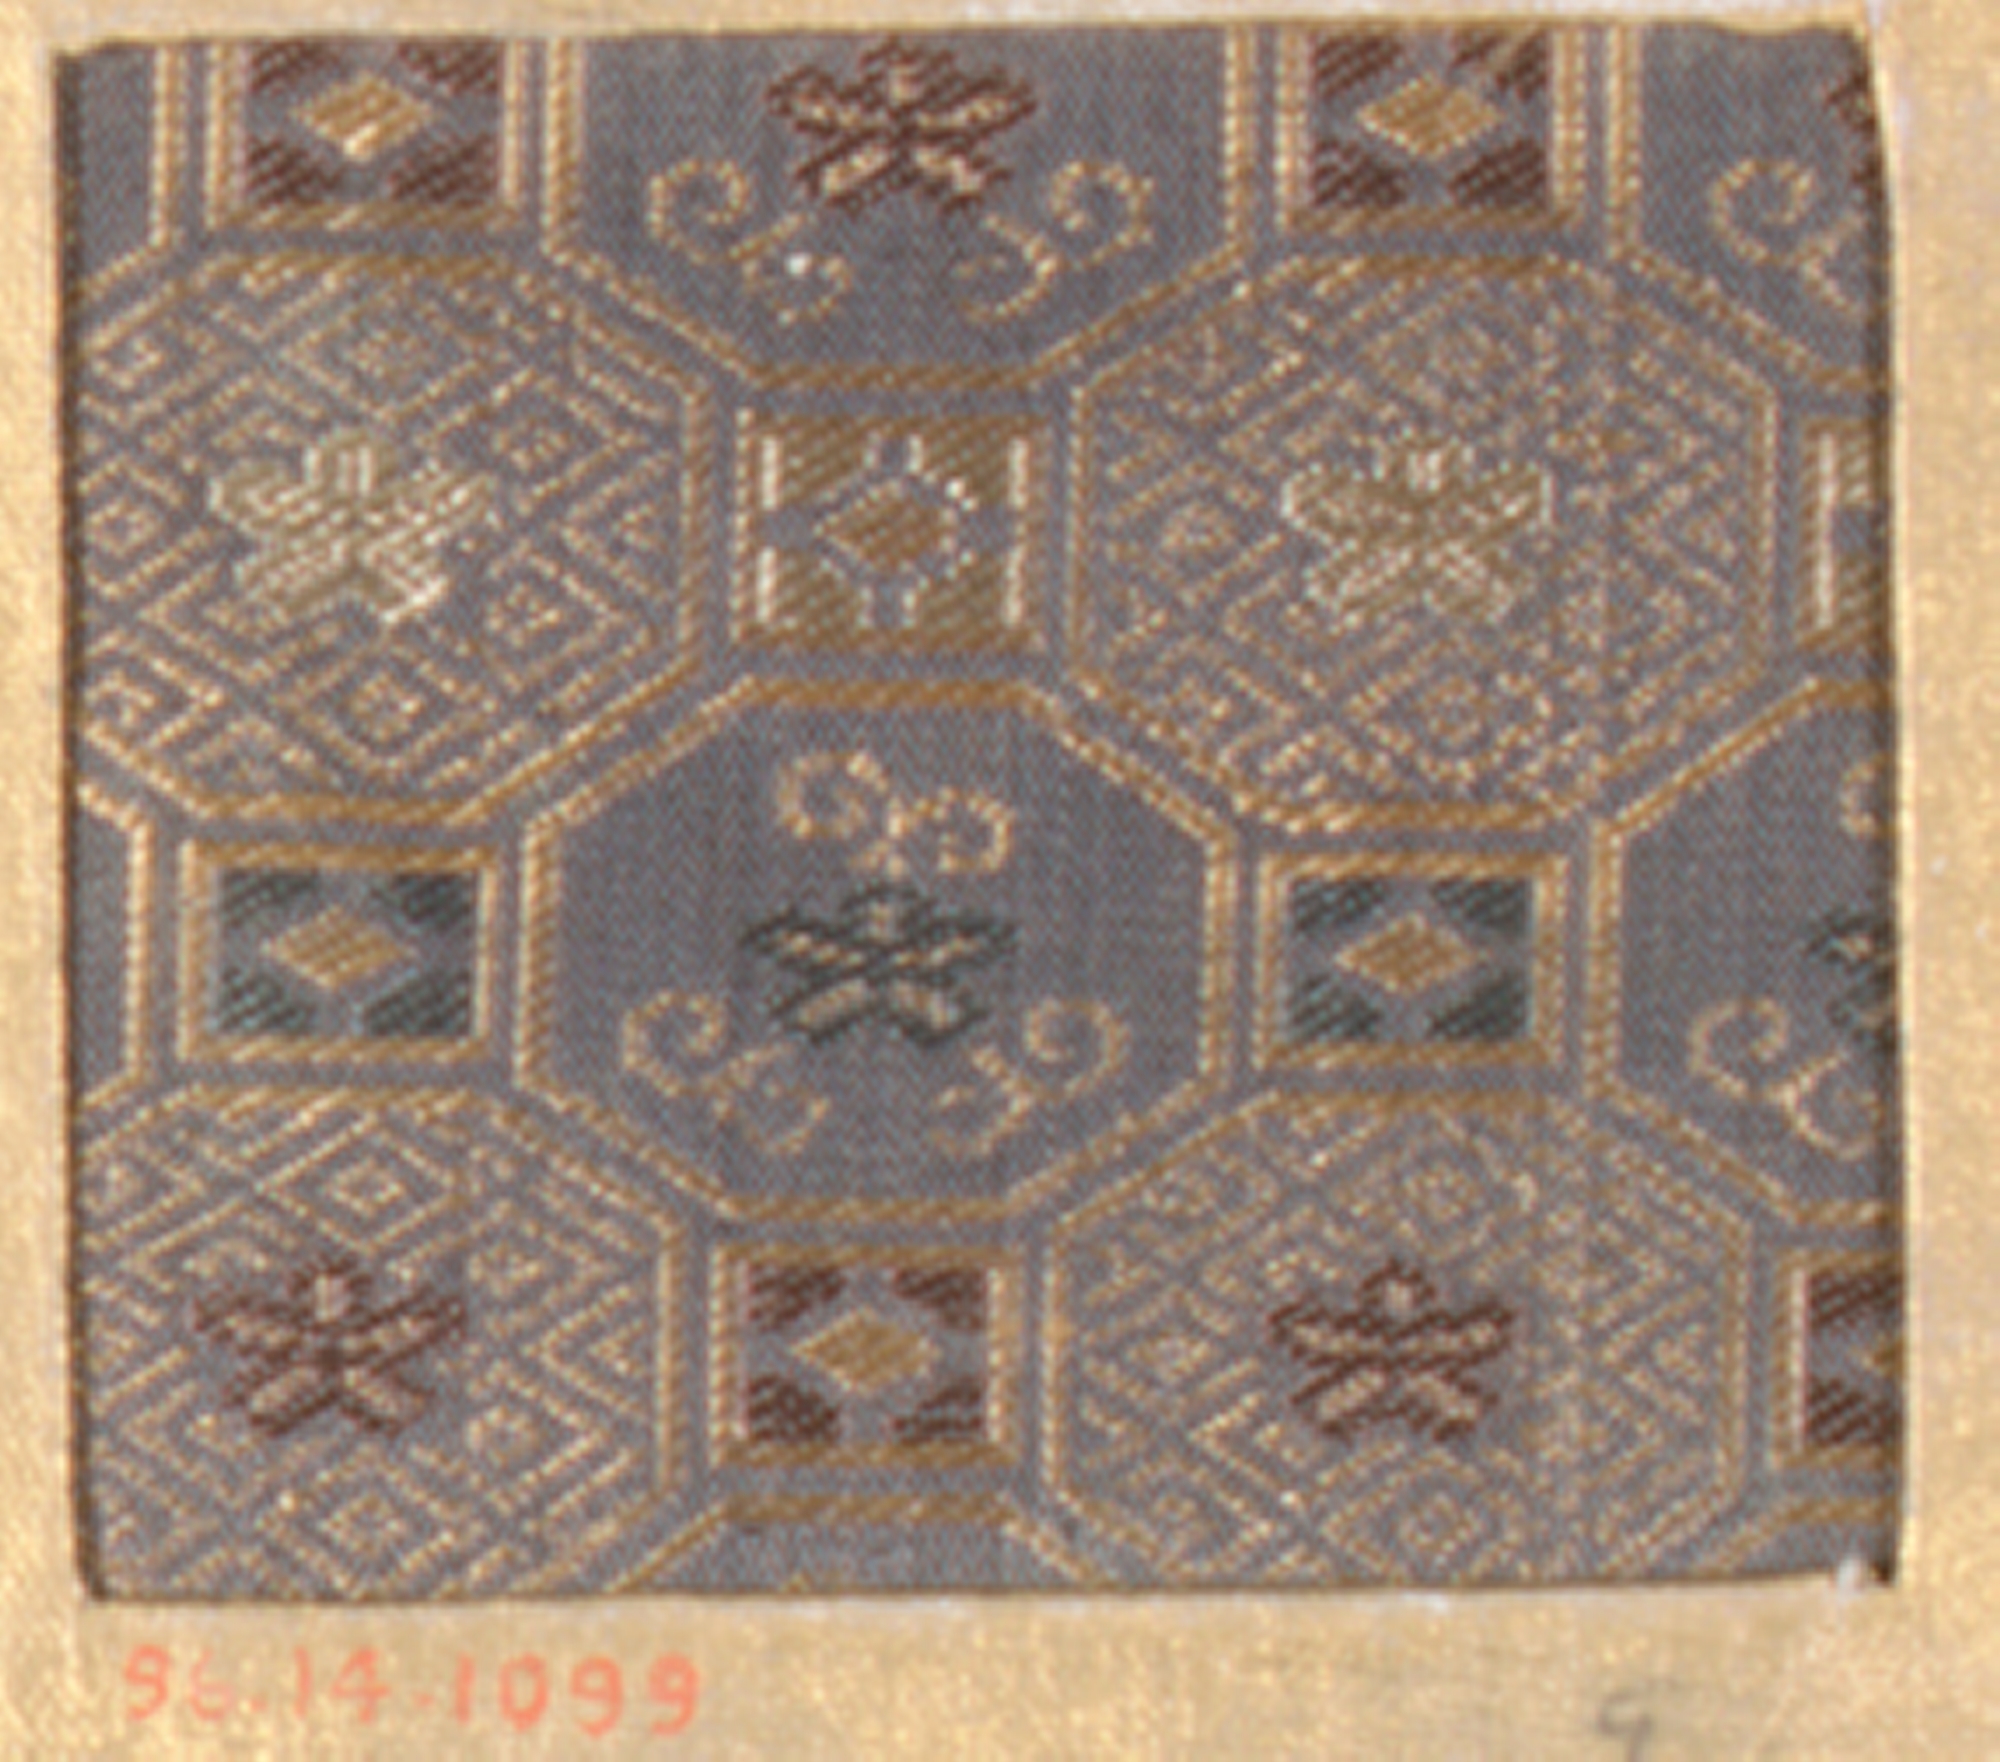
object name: piece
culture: japanese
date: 1701-1900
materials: silk